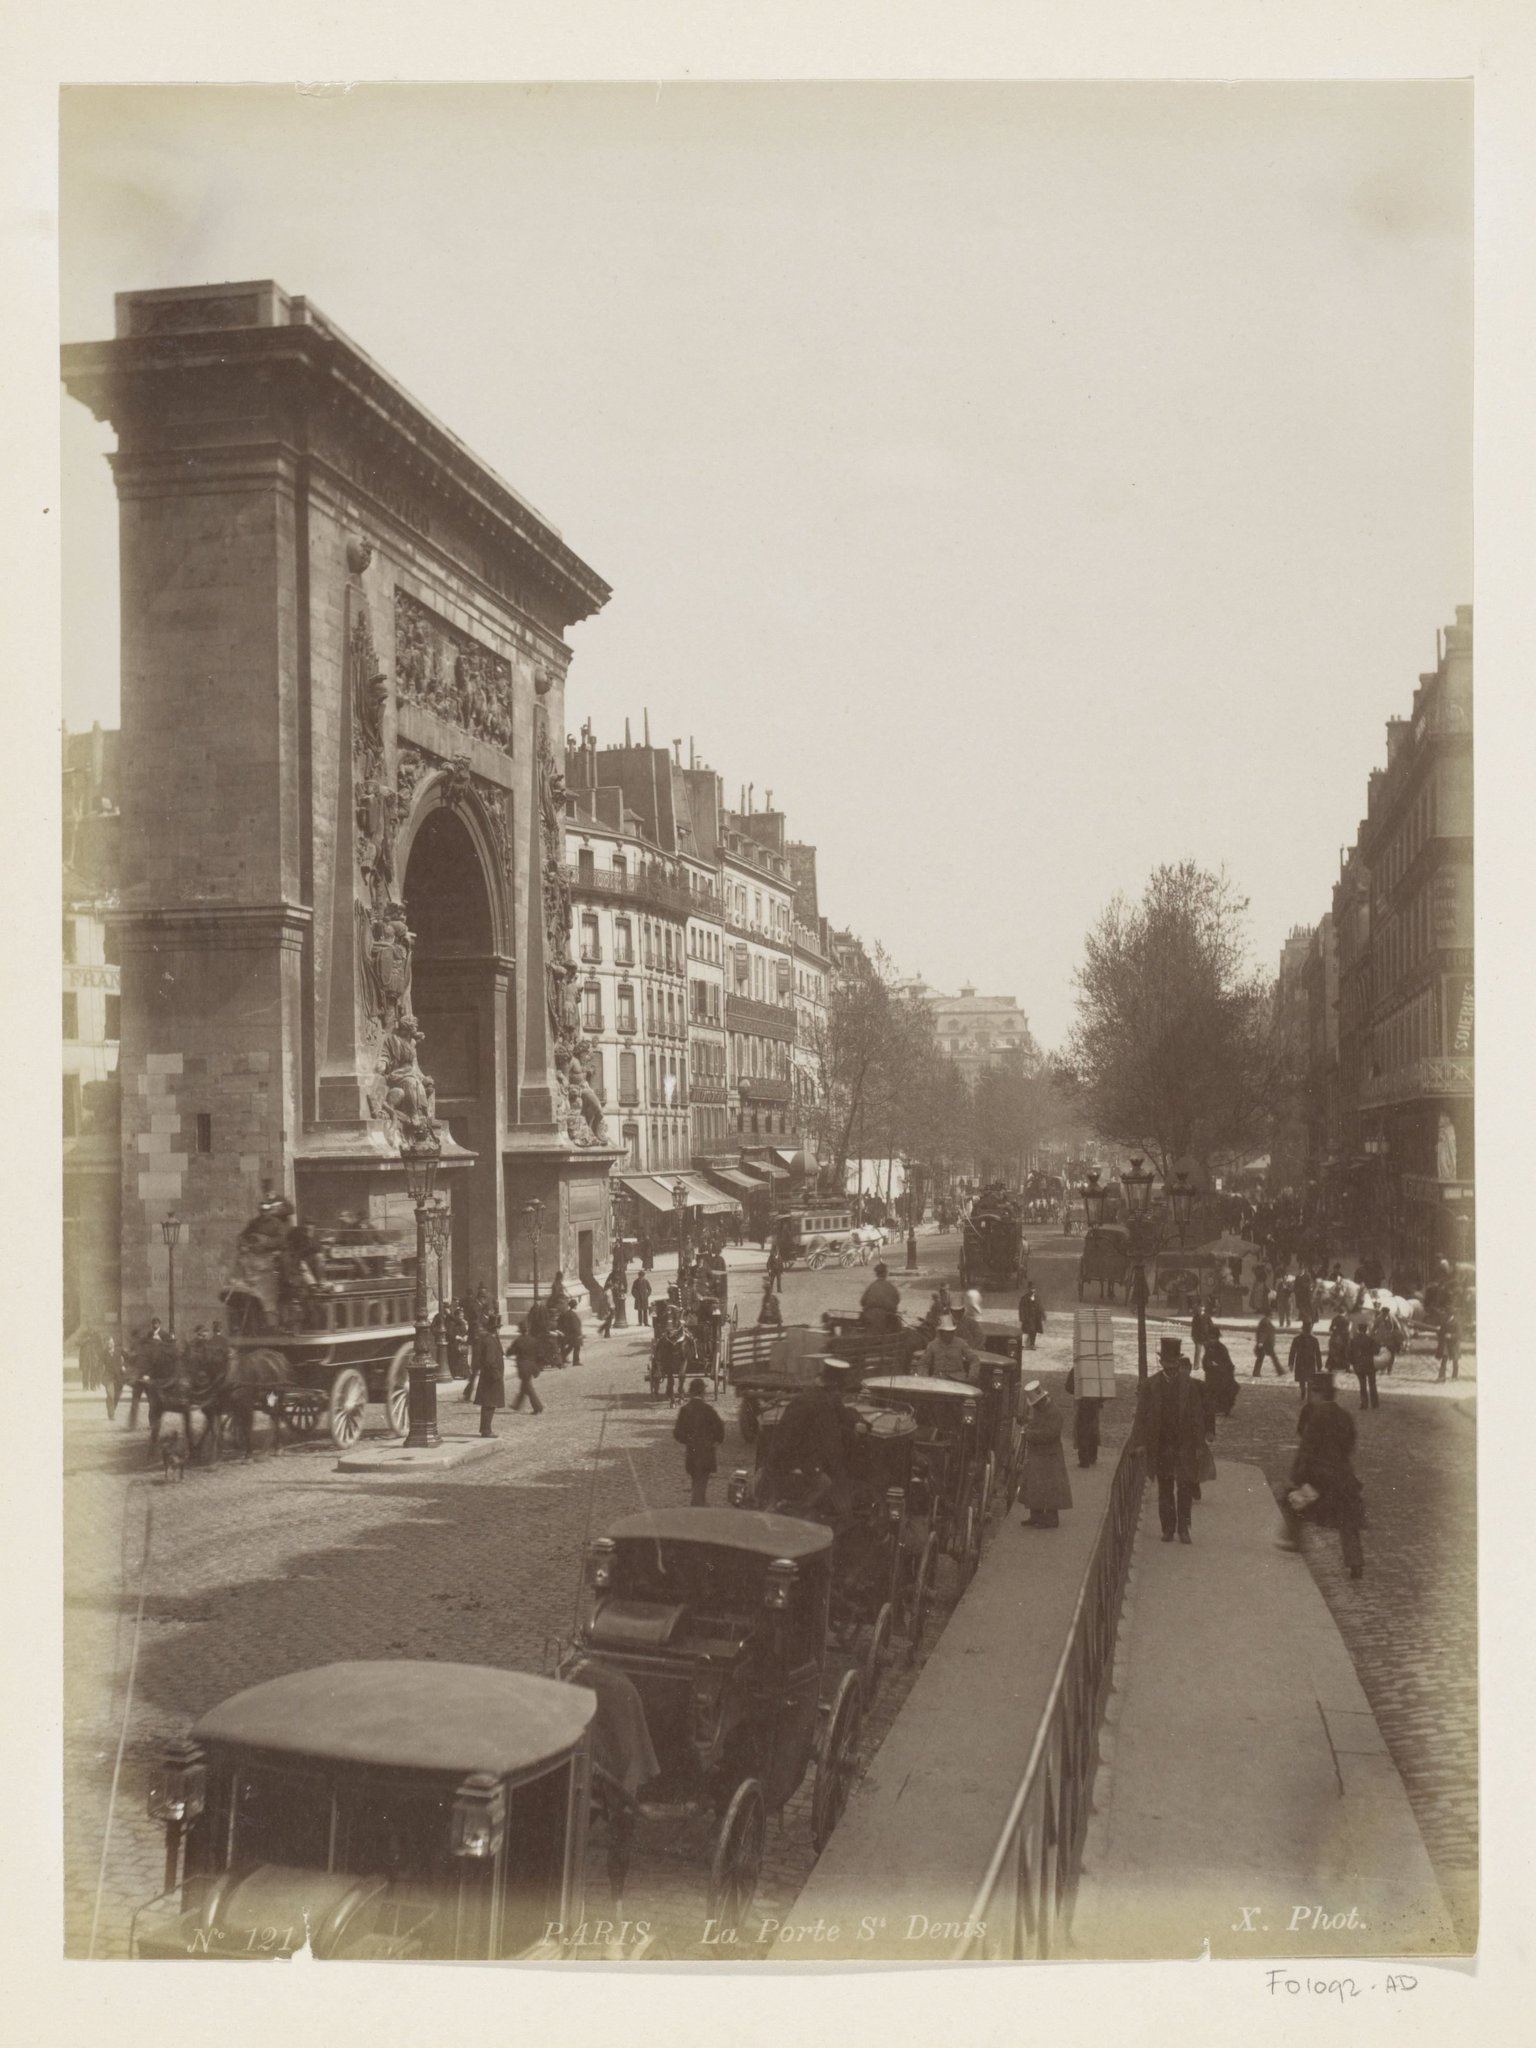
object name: photograph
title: Boulevard de Bonne-Nouvelle in Parijs met links de Porte Saint-Denis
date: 1880-1900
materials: cardboard, paper, photographic support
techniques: albumen print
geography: paris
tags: diligence, omnibus, horse-tram, triumphal arch, four-wheeled, animal-drawn vehicle, e.g.: cab, carriage, coach, street (+ city(-scape) with figures, staffage)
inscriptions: negative number: ‘121’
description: Onderdeel van Reisalbum met foto's van bezienswaardigheden in België en Frankrijk.